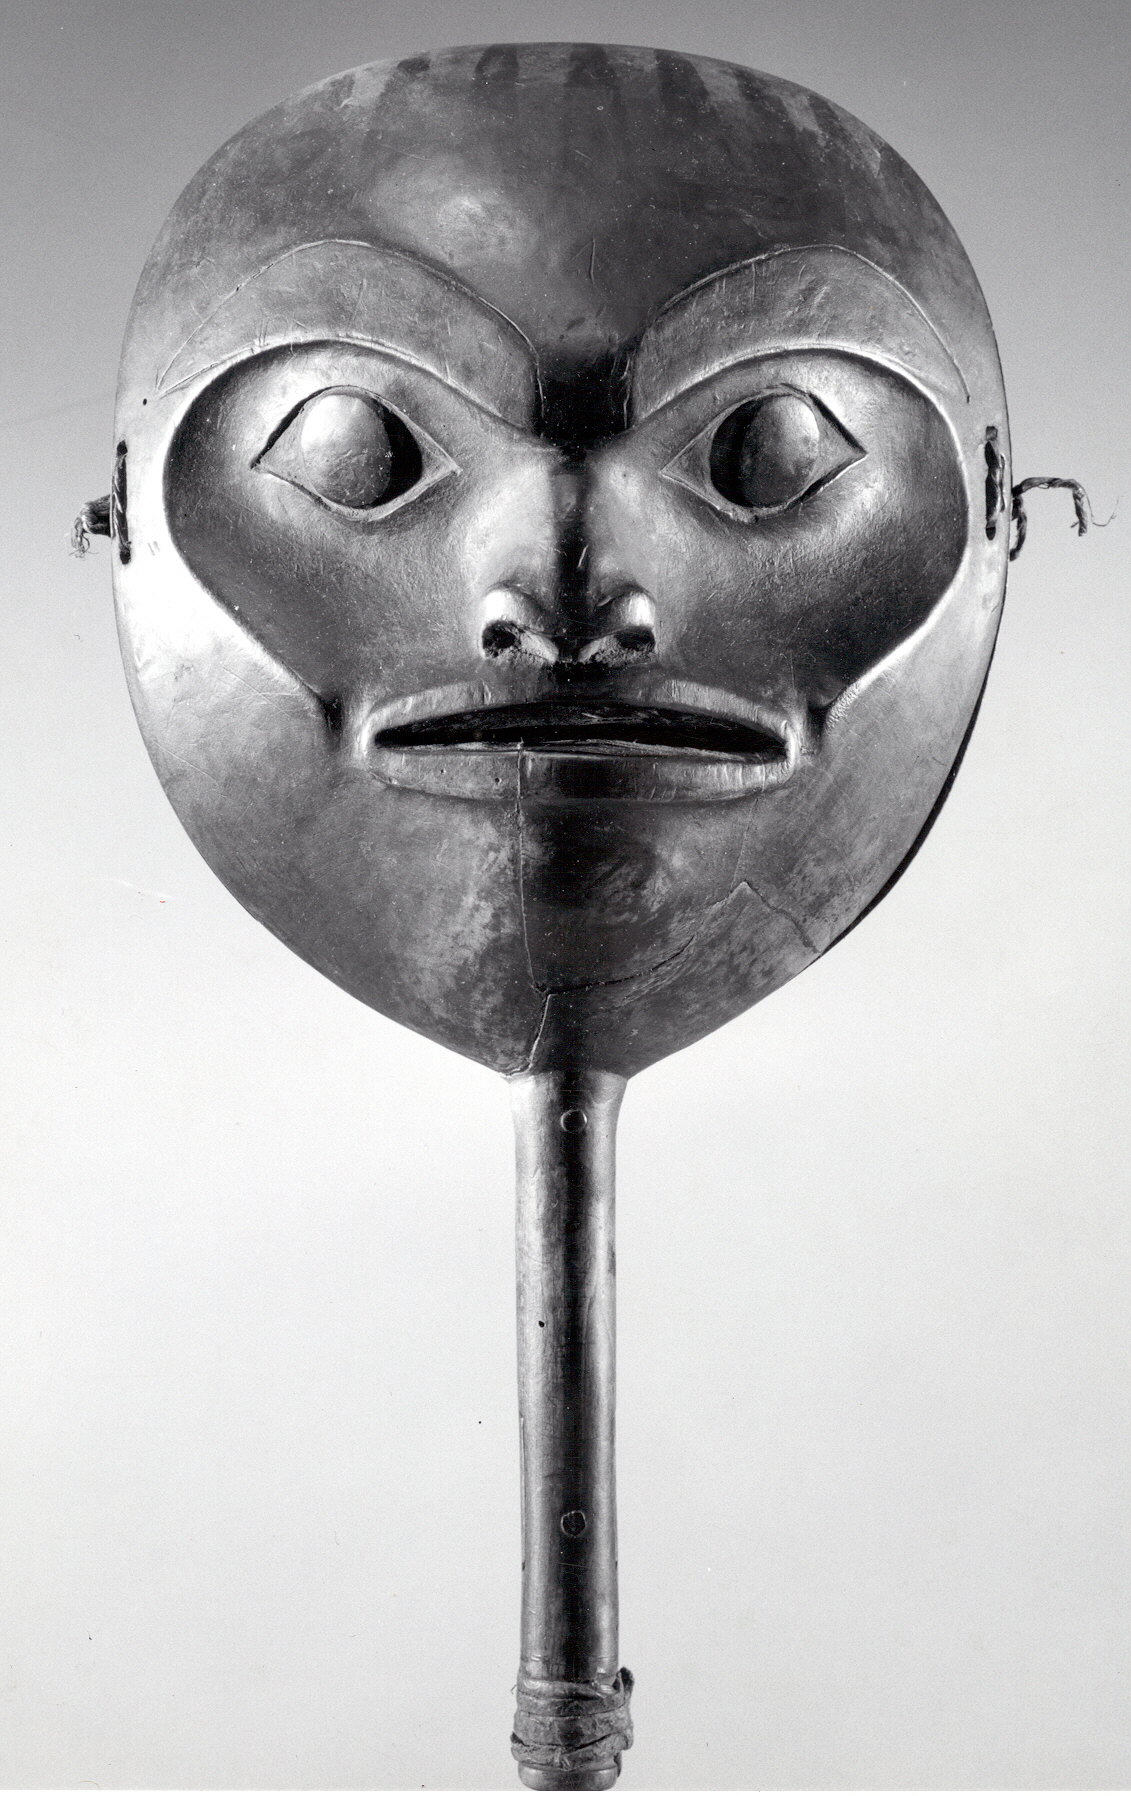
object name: rattle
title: Face Rattle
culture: tsimshian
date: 1834-1866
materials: fiber, leather, wood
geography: canada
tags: musical instruments,faces